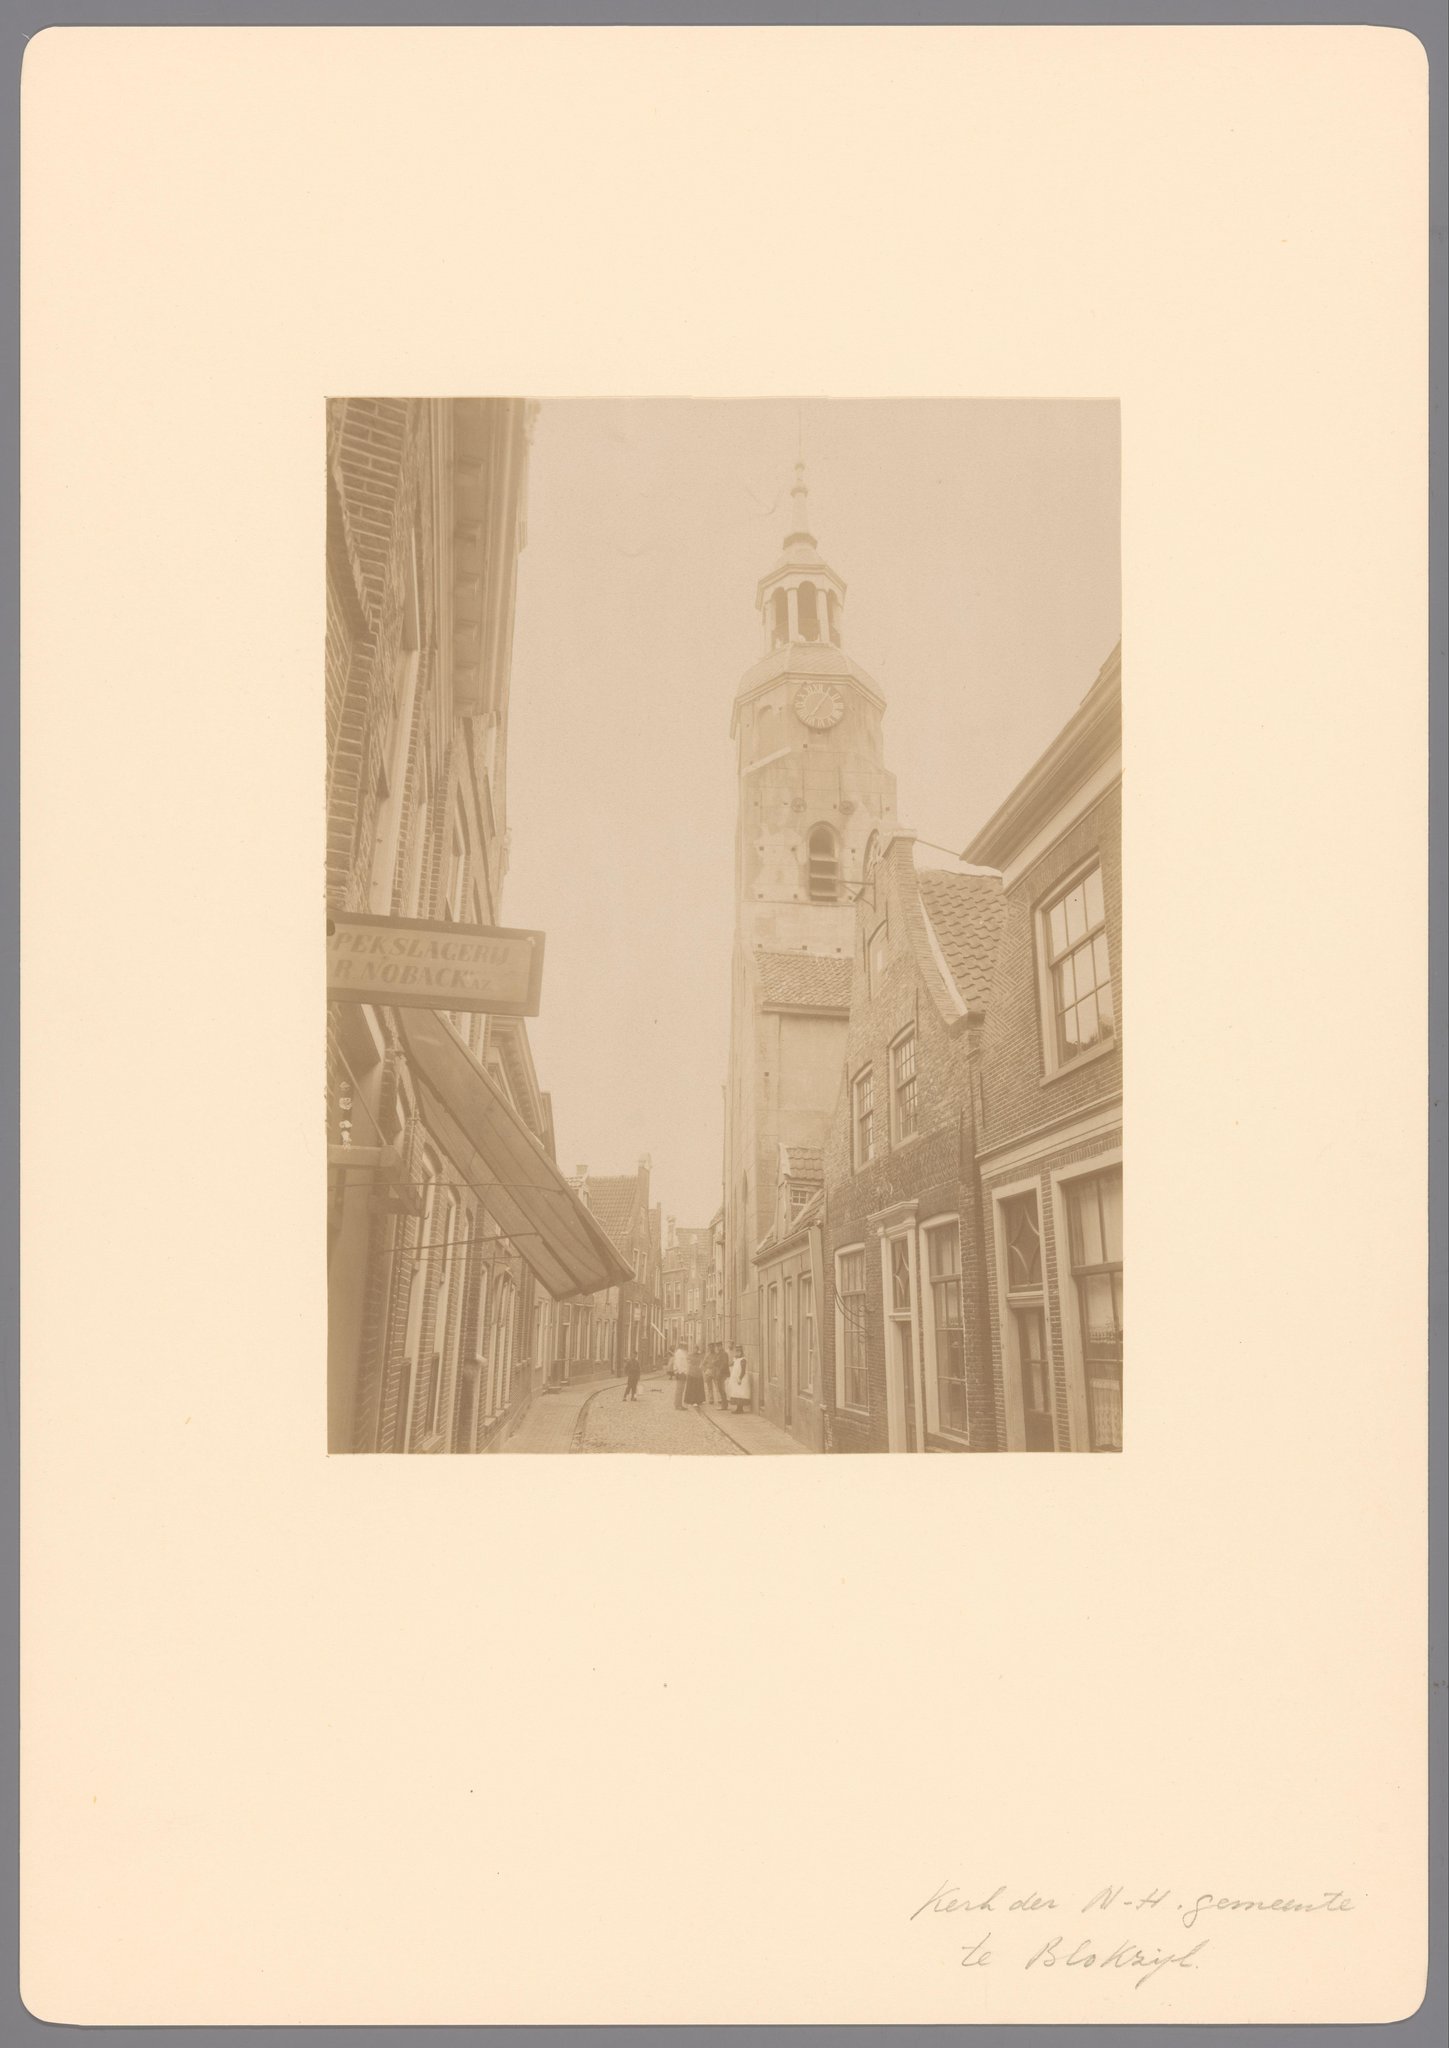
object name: photograph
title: Gezicht op de Hervormde Kerk te Blokzijl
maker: anoniem (monumentenzorg)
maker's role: fotograaf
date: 1890-1910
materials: cardboard, photographic support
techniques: albumen print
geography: blokzijl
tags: street (+ city(-scape) with figures, staffage), parts of church exterior and annexes: tower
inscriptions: annotation: ‘Kerk der N-H gemeente te Blokzijl’